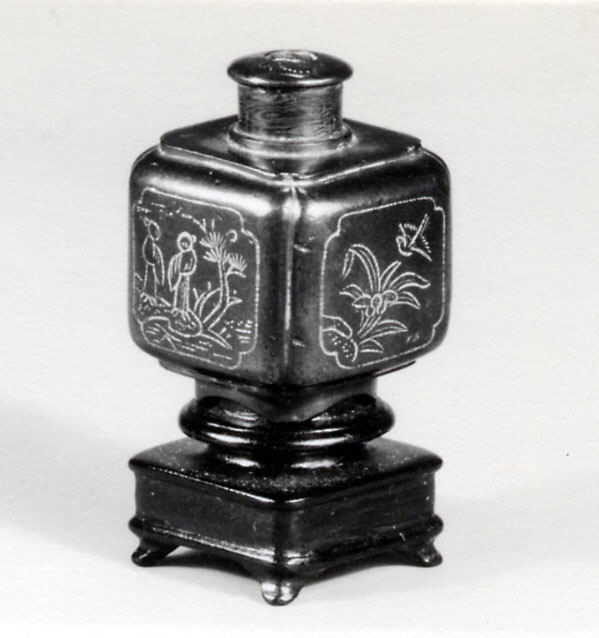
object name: bottle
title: Miniature Bottle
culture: chinese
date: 1701-1800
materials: copper, gold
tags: human figures